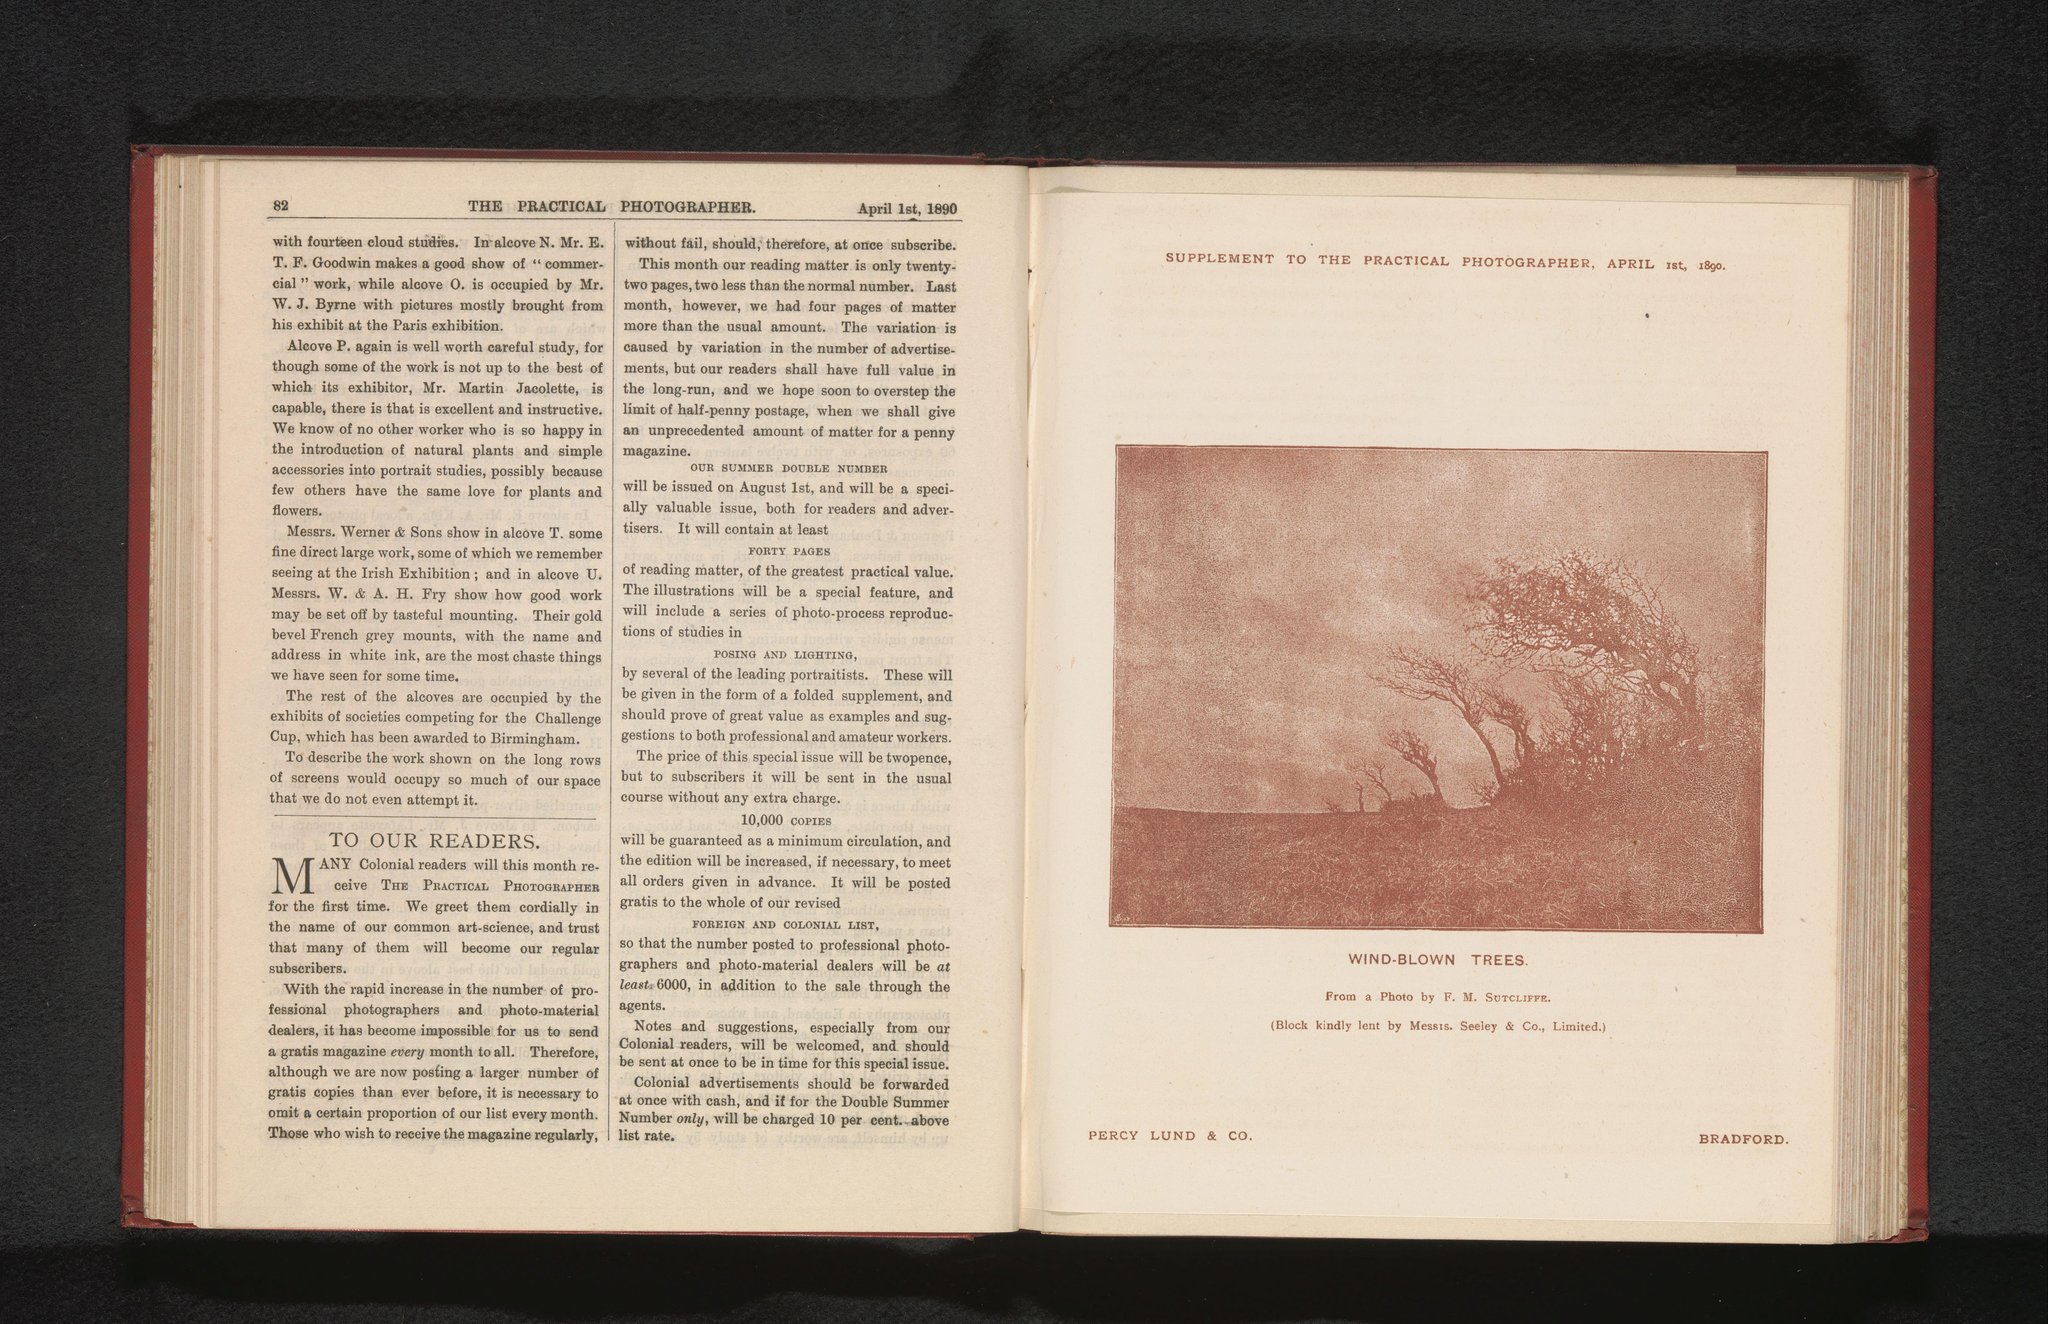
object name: photomechanical print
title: Landschap met bomen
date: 1885-1890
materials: paper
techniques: autotype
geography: bradford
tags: trees, cat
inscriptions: inscription: ‘(Block kindly lent by Messrs. Seeley & Co., Limited.)’, inscription: ‘SUPPLEMENT TO THE PRACTICAL PHOTOGRAPHER, APRIL 1st, 1890.’, monogram: ‘AGph.’